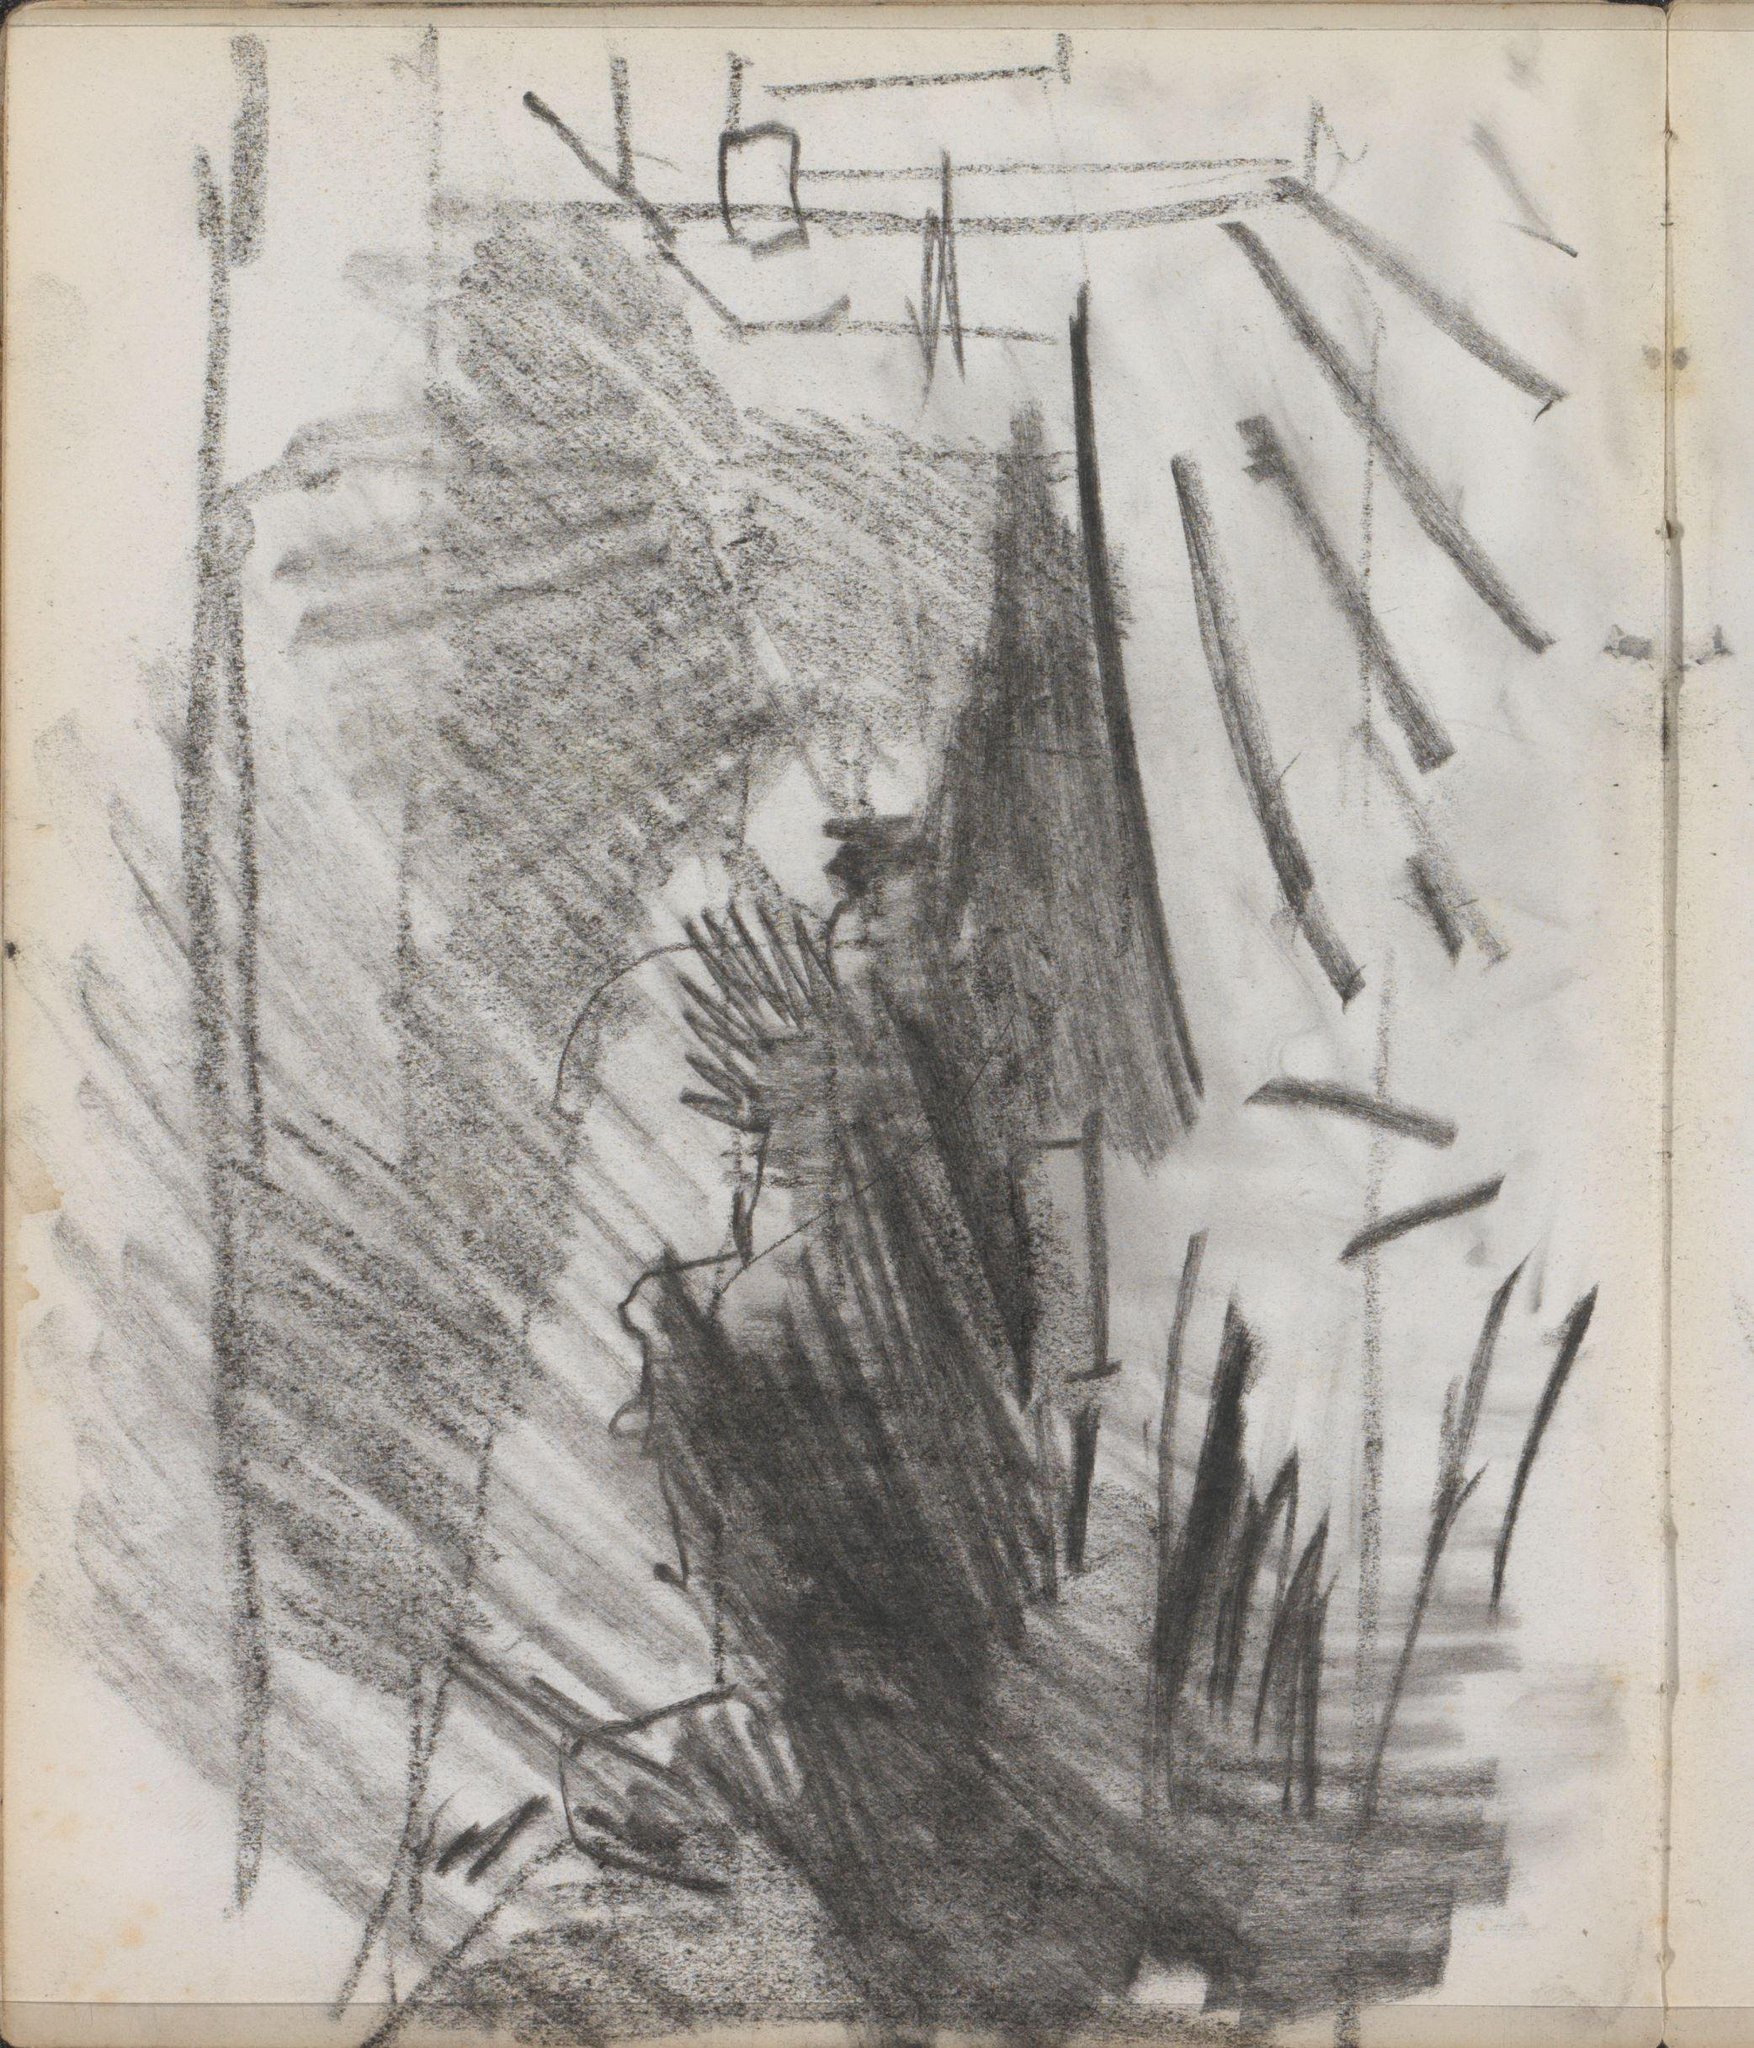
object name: sketchbook leaf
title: Bebouwing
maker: george hendrik breitner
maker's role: draughtsman, painter, print maker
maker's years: 1857-1923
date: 1880-1906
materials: chalk, paper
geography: netherlands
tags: architecture, civic architecture; edifices; dwellings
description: Pagina 19 uit een schetsboek met 81 bladen.